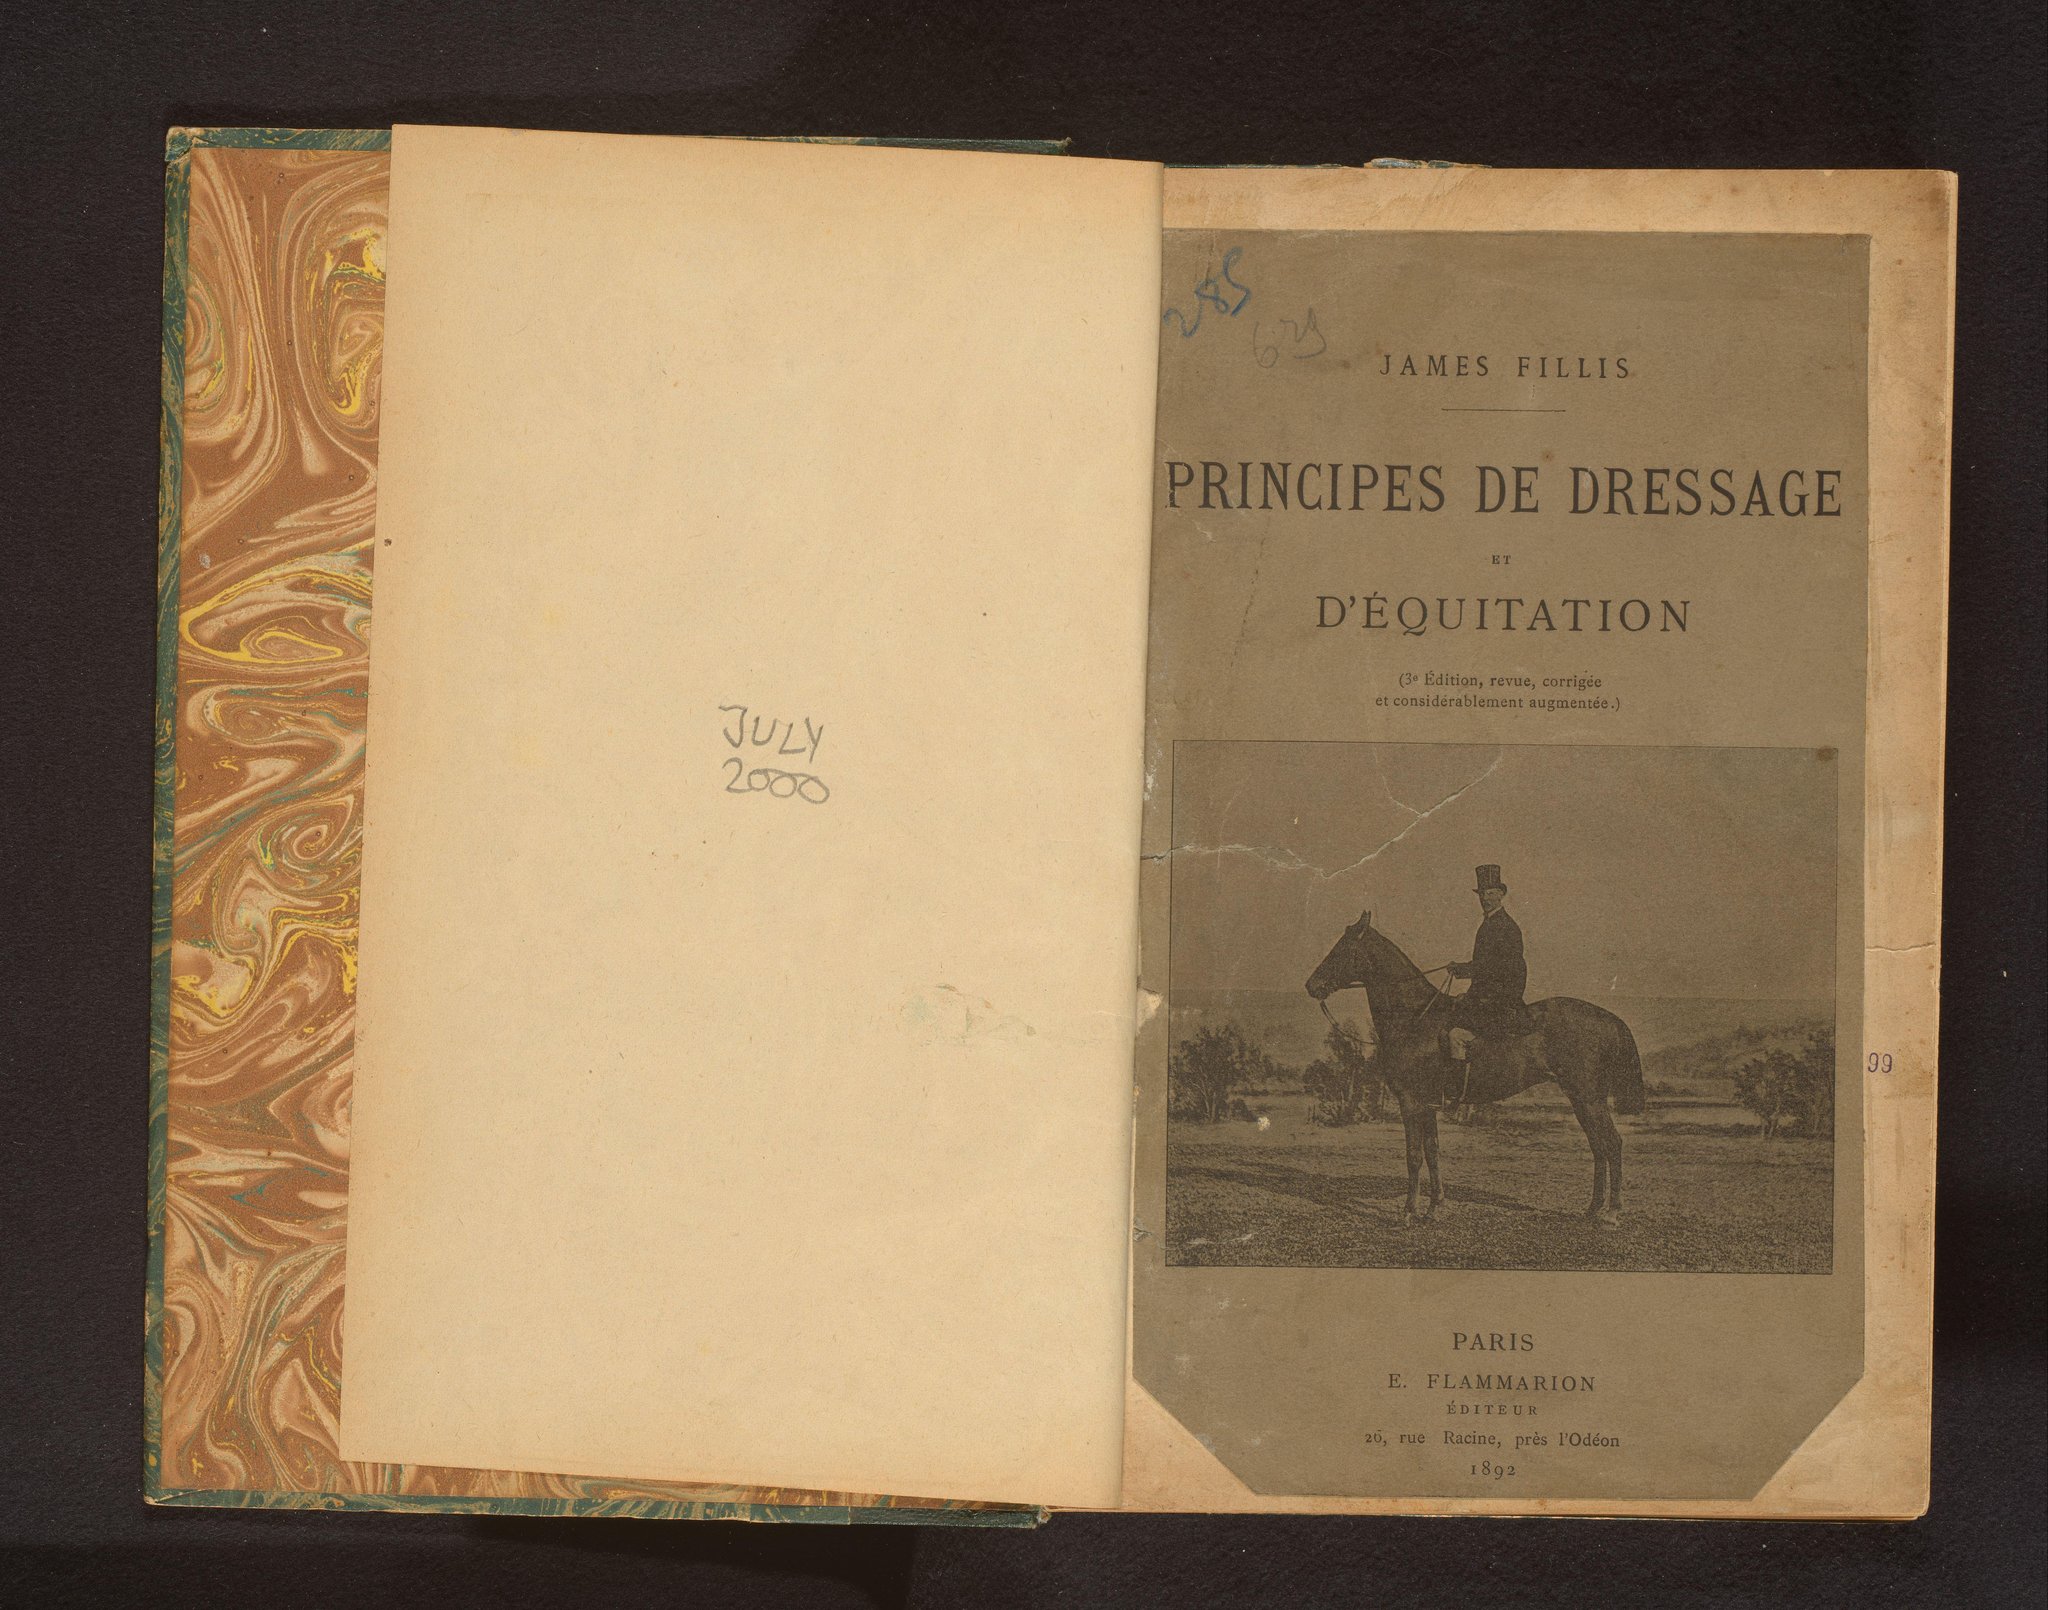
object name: book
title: Principes de dressage et d'équitation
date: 1892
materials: cardboard, leather, paper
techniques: marbled paper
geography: paris